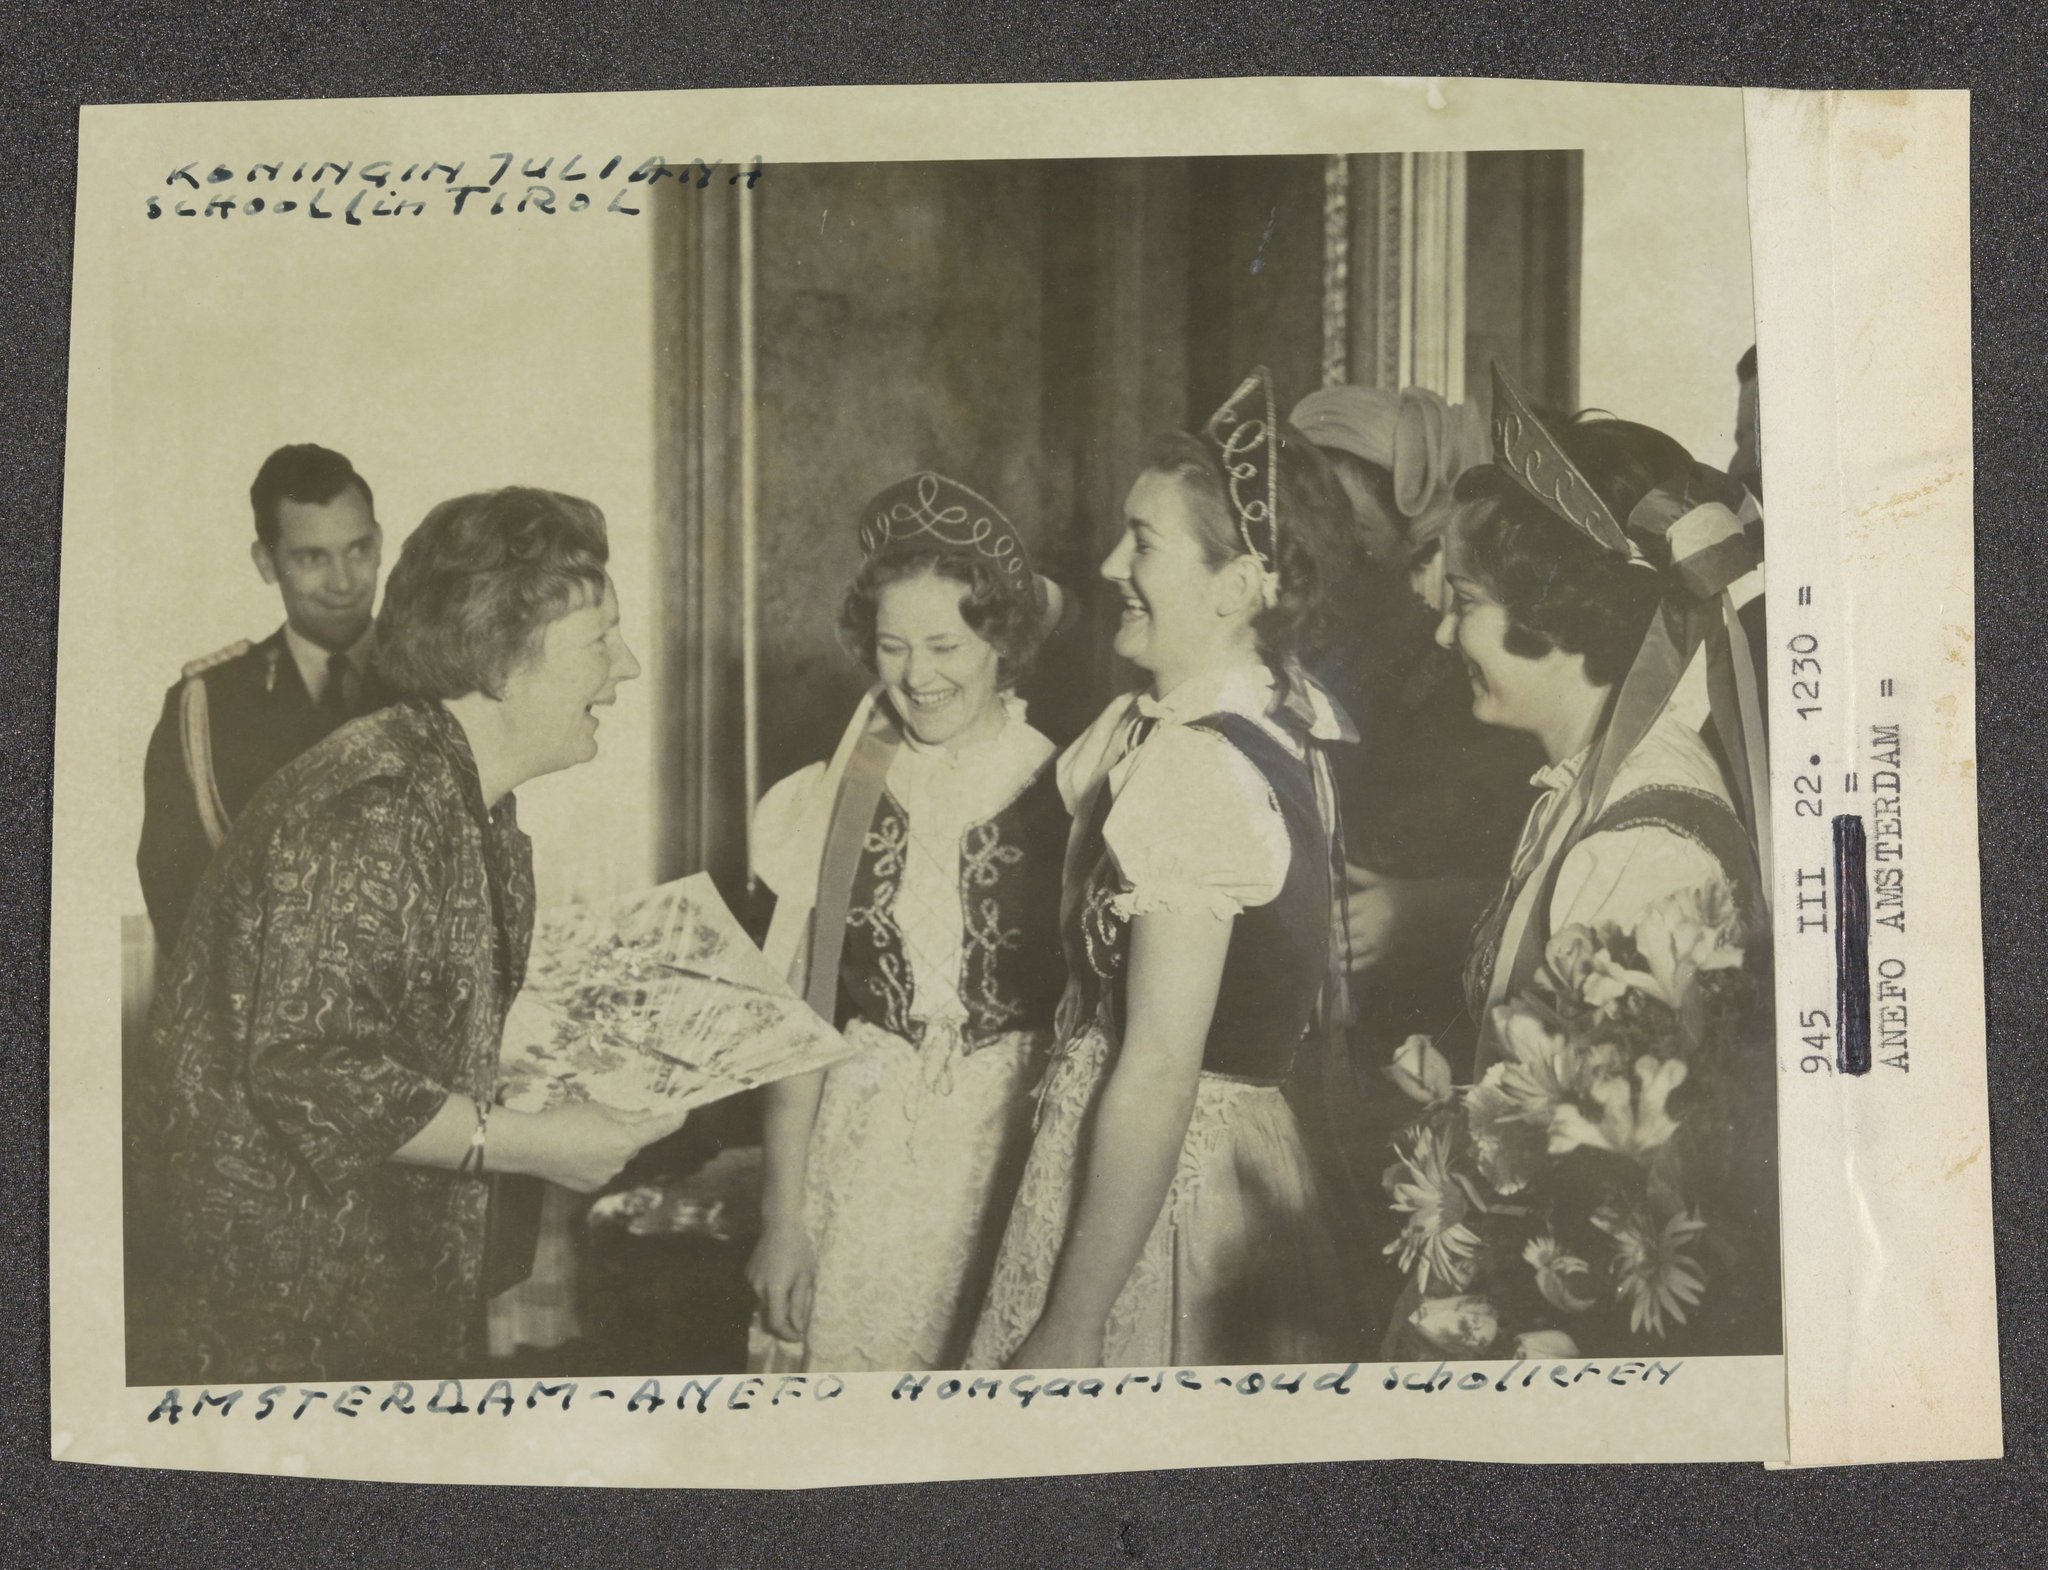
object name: photograph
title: Koningin Juliana op bezoek op een school in Tirol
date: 1945-1970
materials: paper, photographic support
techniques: gelatin silver print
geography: amsterdam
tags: juliana of the netherlands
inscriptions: name: ‘anefo amsterdam 945 III 22. 1230’